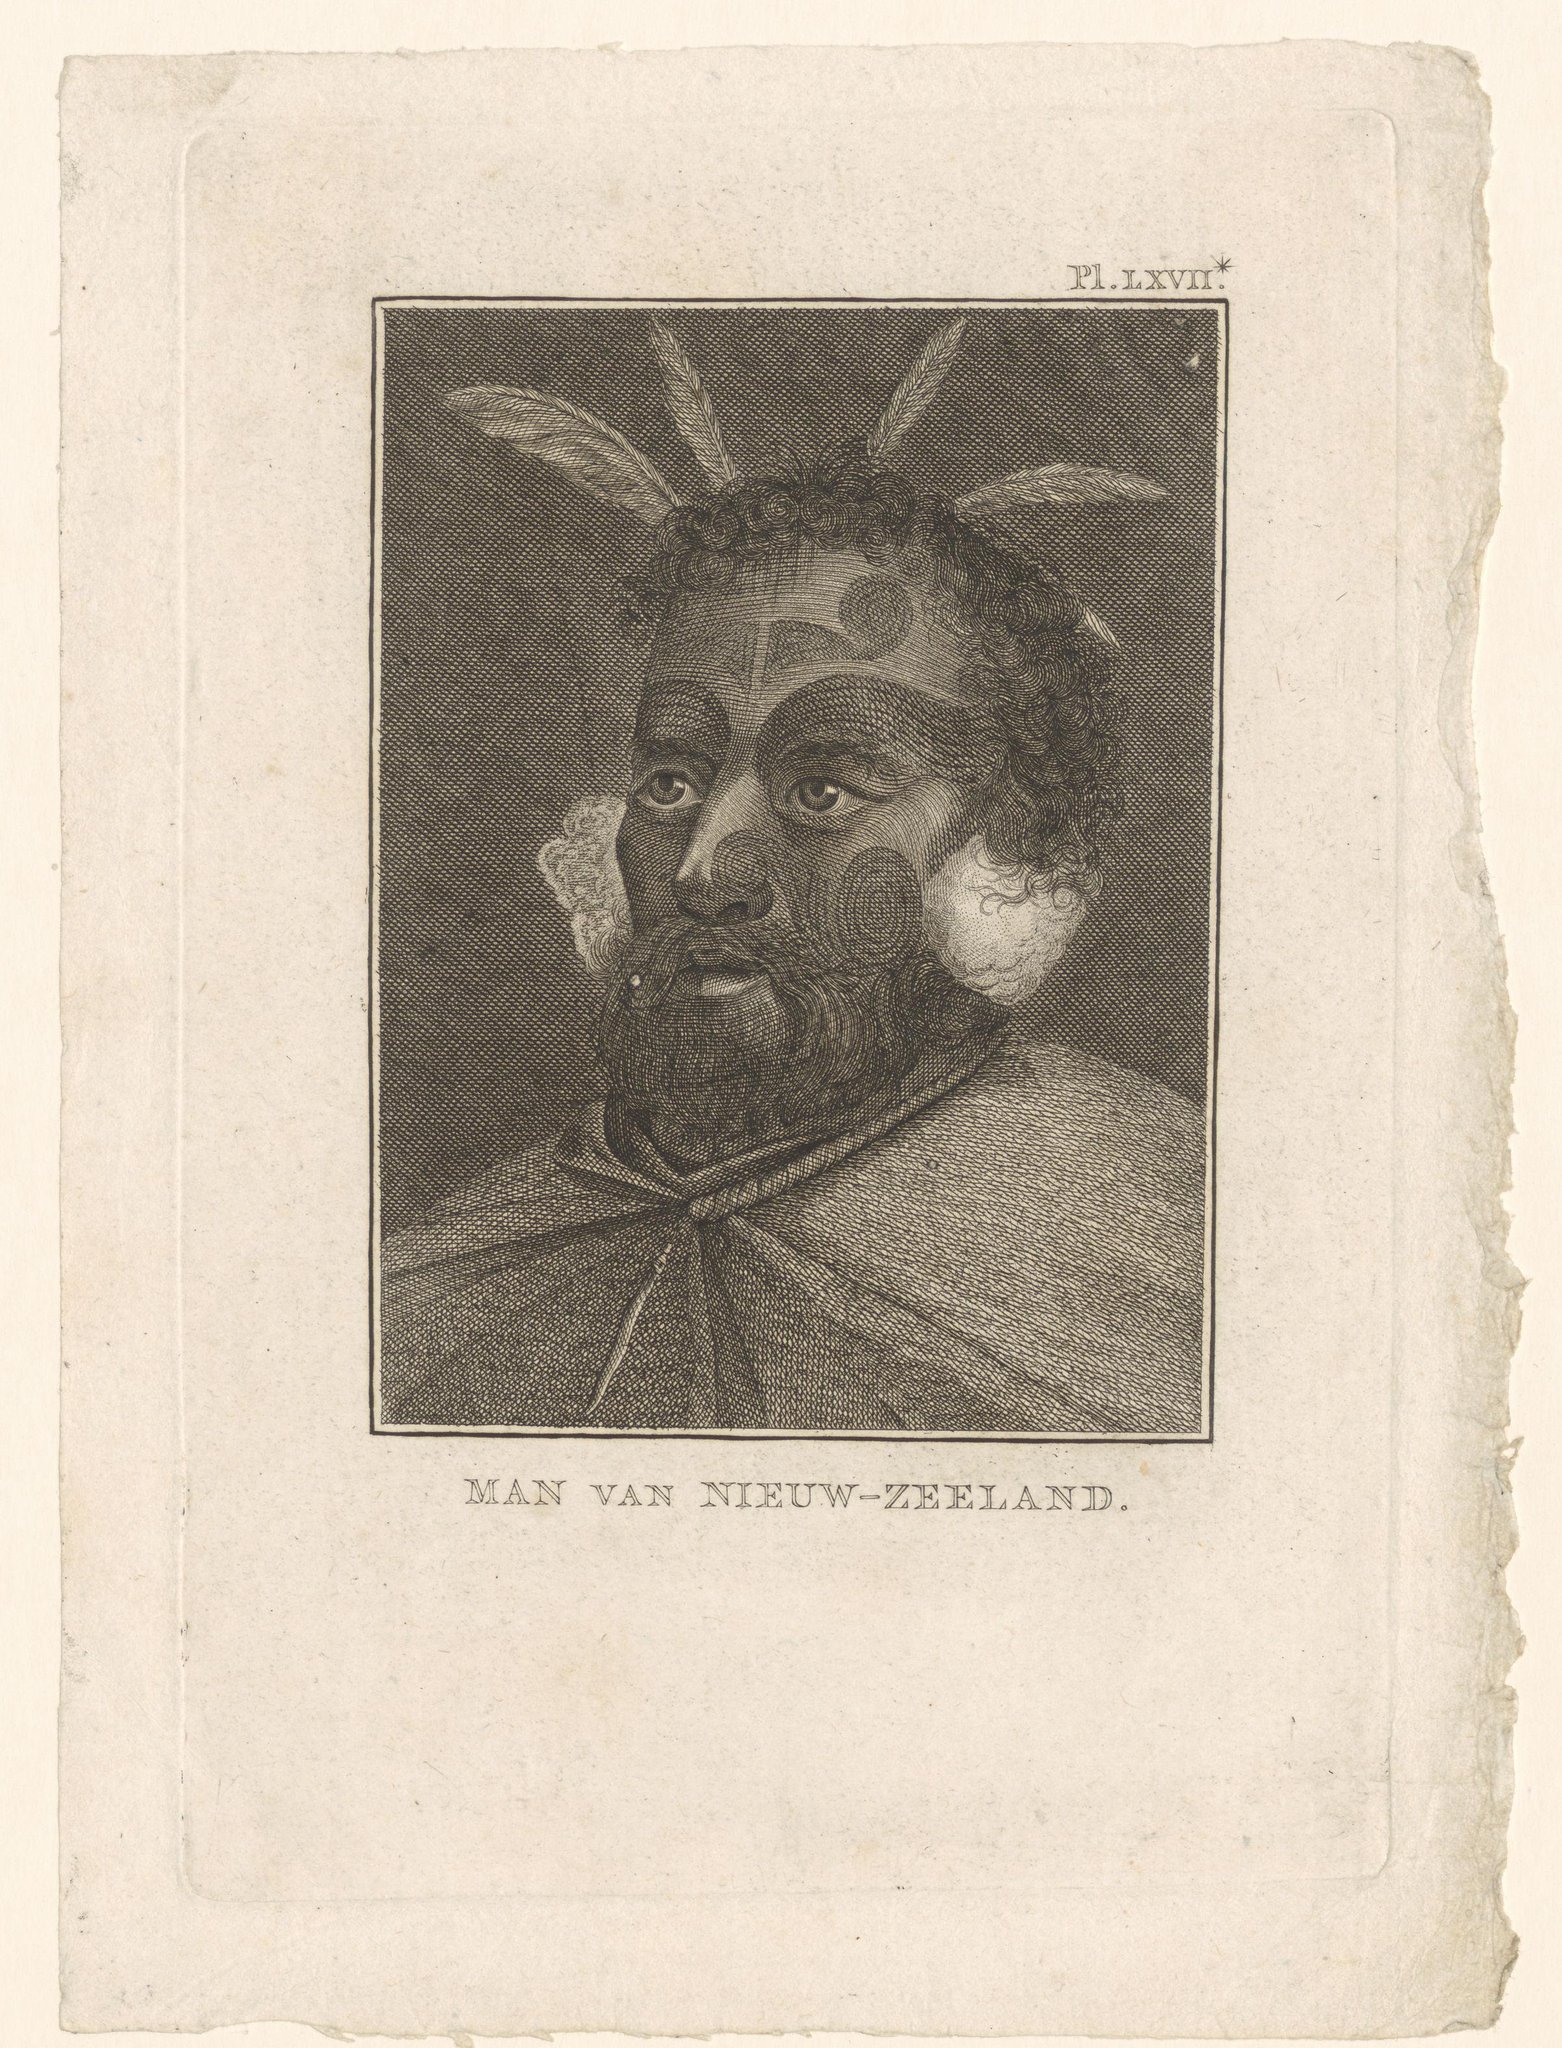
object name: print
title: Portret van een onbekende man afkomstig uit Nieuw-Zeeland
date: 1795-1803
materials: paper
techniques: engraving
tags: adult man, anonymous historical person portrayed, folk costume, regional costume, new zealand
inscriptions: number: ‘LXVII’, collector's mark: Lugt 2228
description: De prent is gebruikt in: Cook, James. Reize rondom de Waereld (...) met kaarten en plaaten. [Vertaald uit het Engels door] Jan David Pasteur. Leiden: Honkoop, Amsterdam: Allart, Den Haag: Van Cleef, 1795-1803, dl. 13.